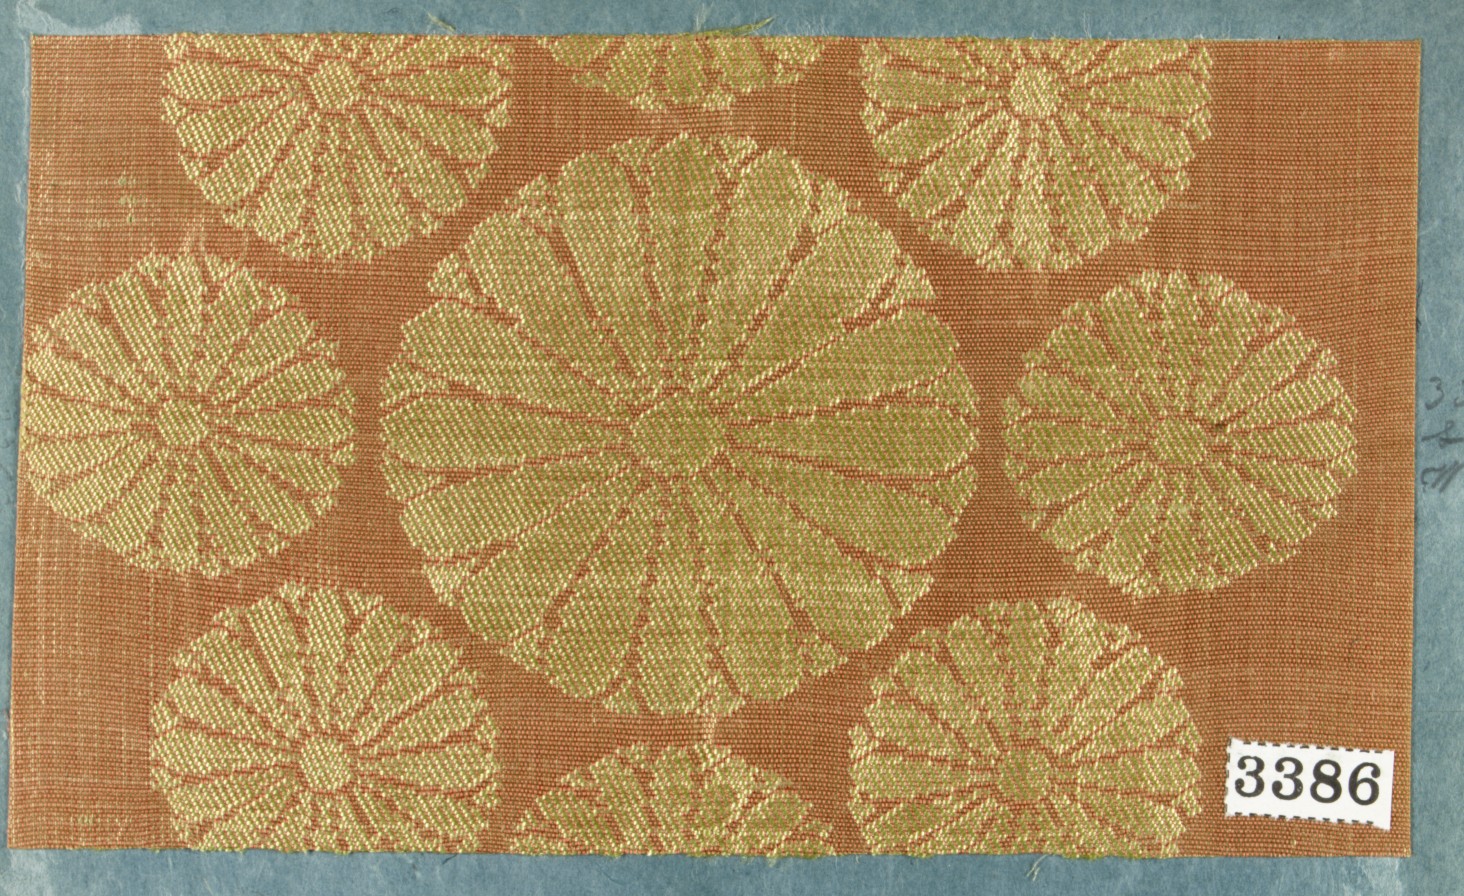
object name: textile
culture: japanese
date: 1801-1900